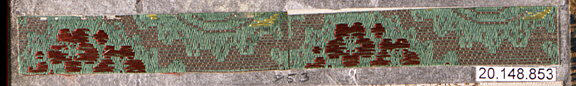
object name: piece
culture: japanese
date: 1701-1800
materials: silk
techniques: compound weave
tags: flowers